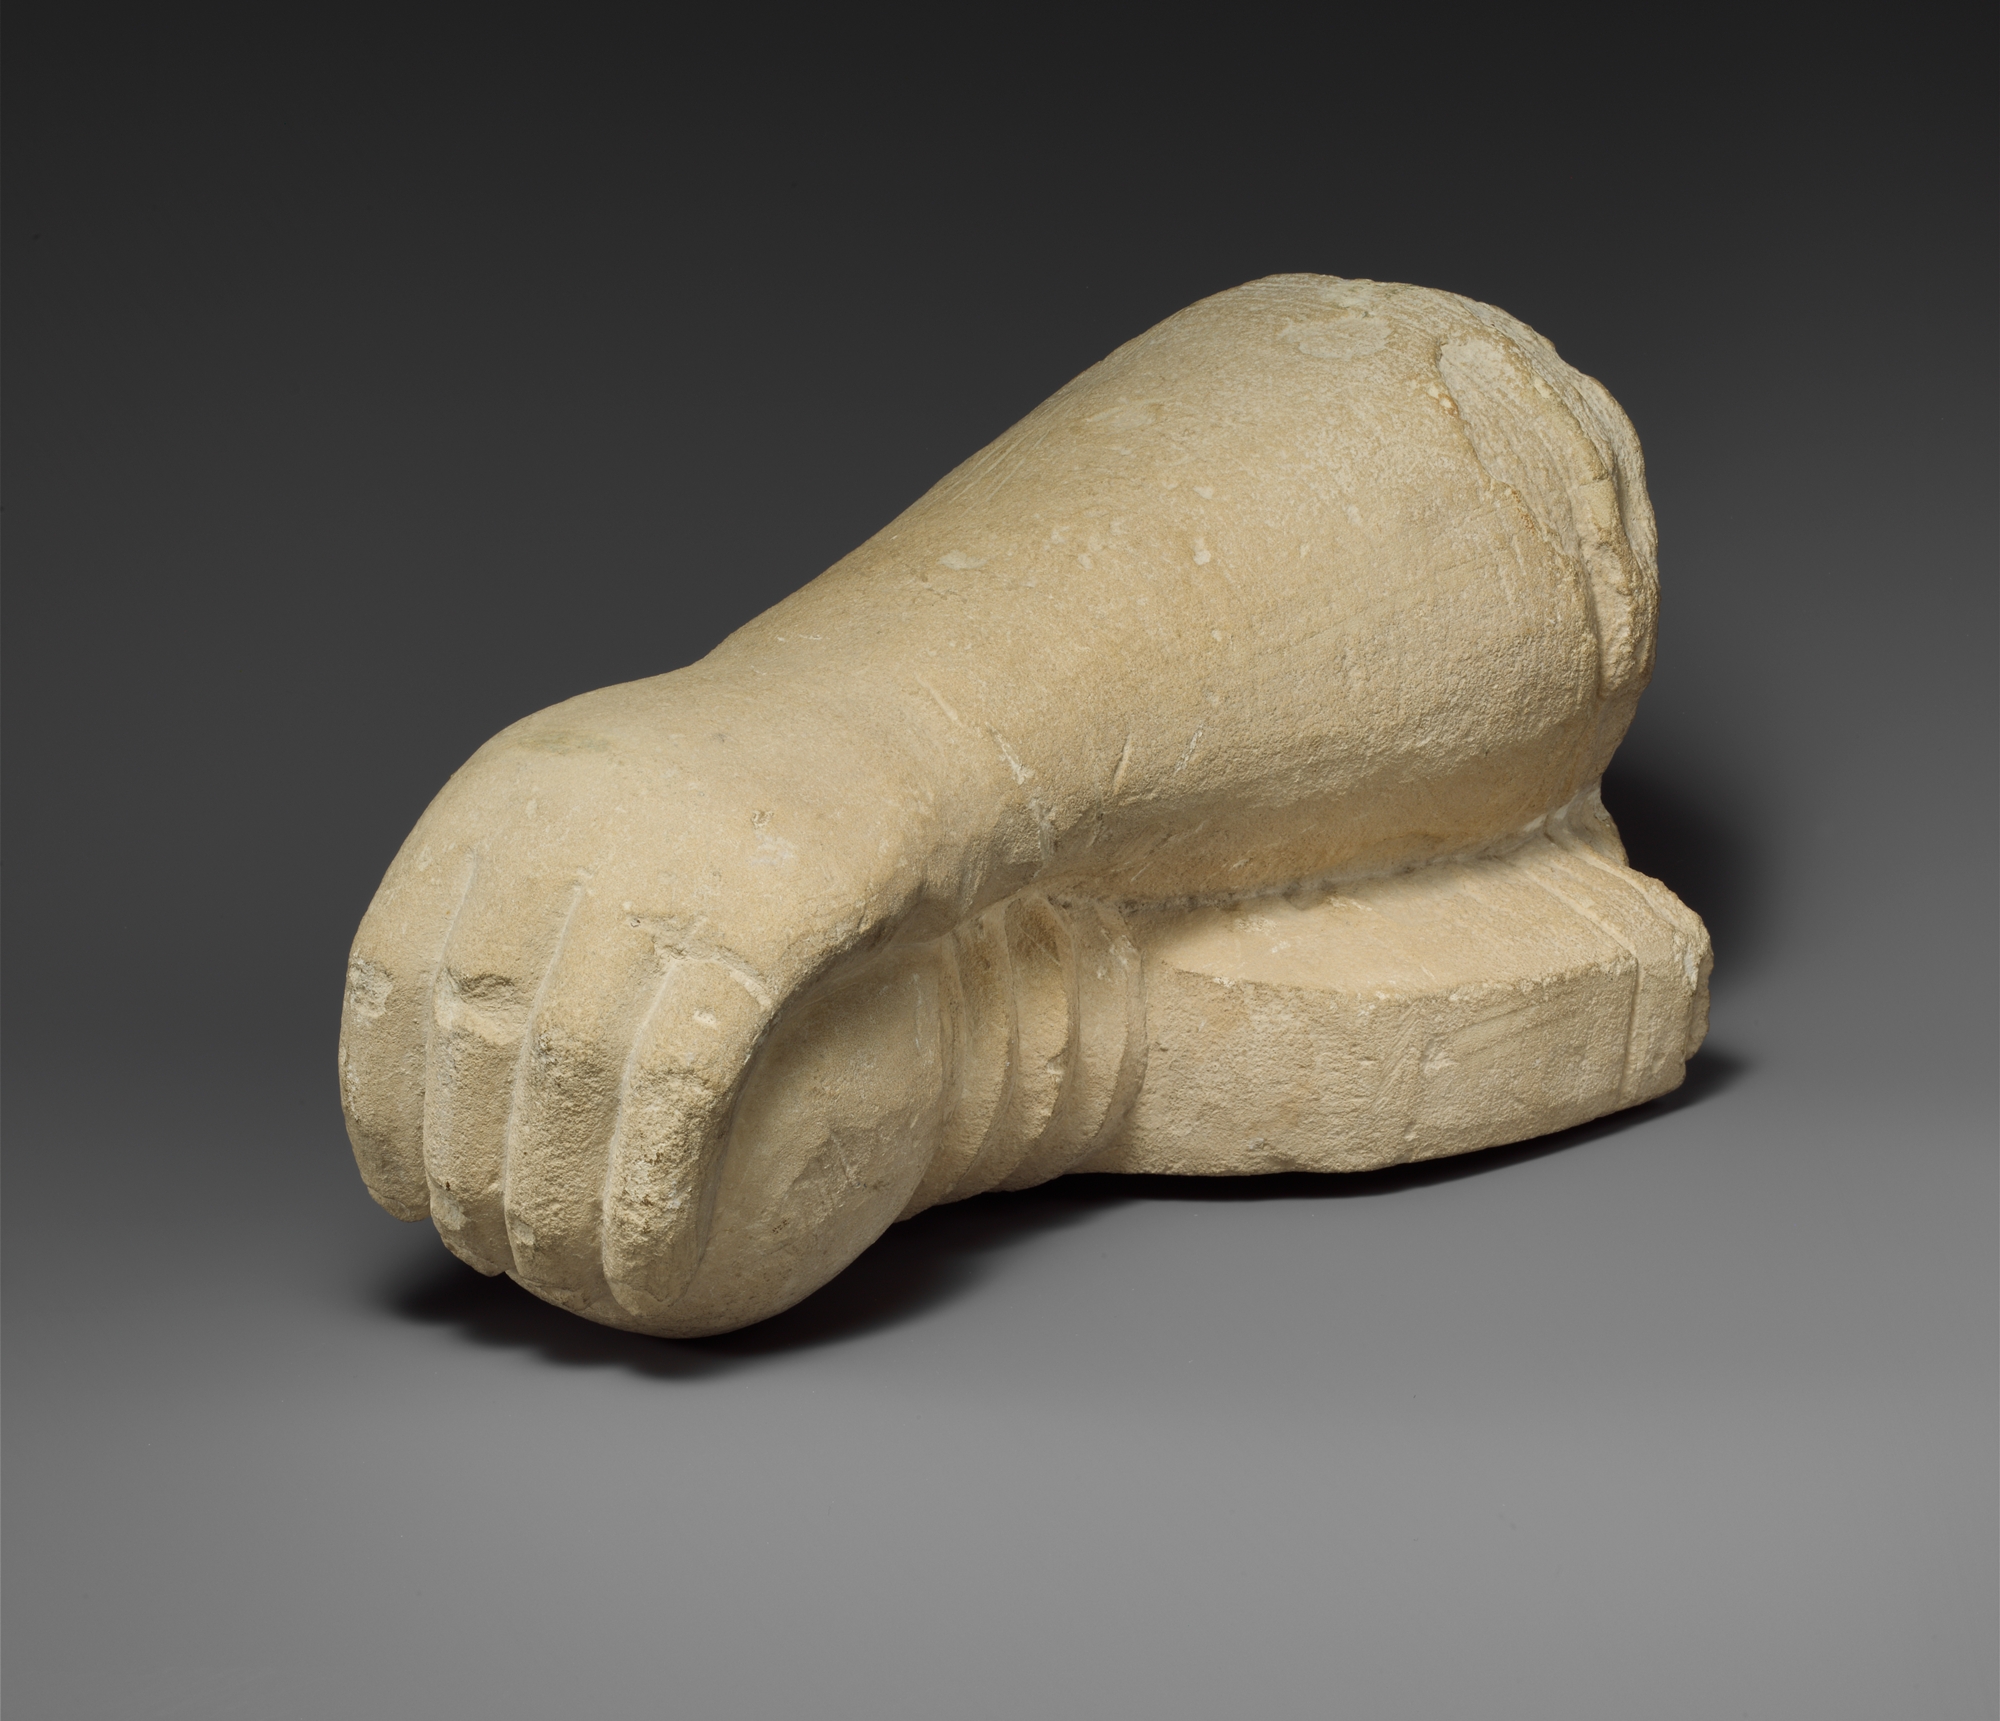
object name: arm and left hand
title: Limestone arm holding a sword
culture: cypriot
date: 300 BCE-100 CE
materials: limestone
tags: swords,hands